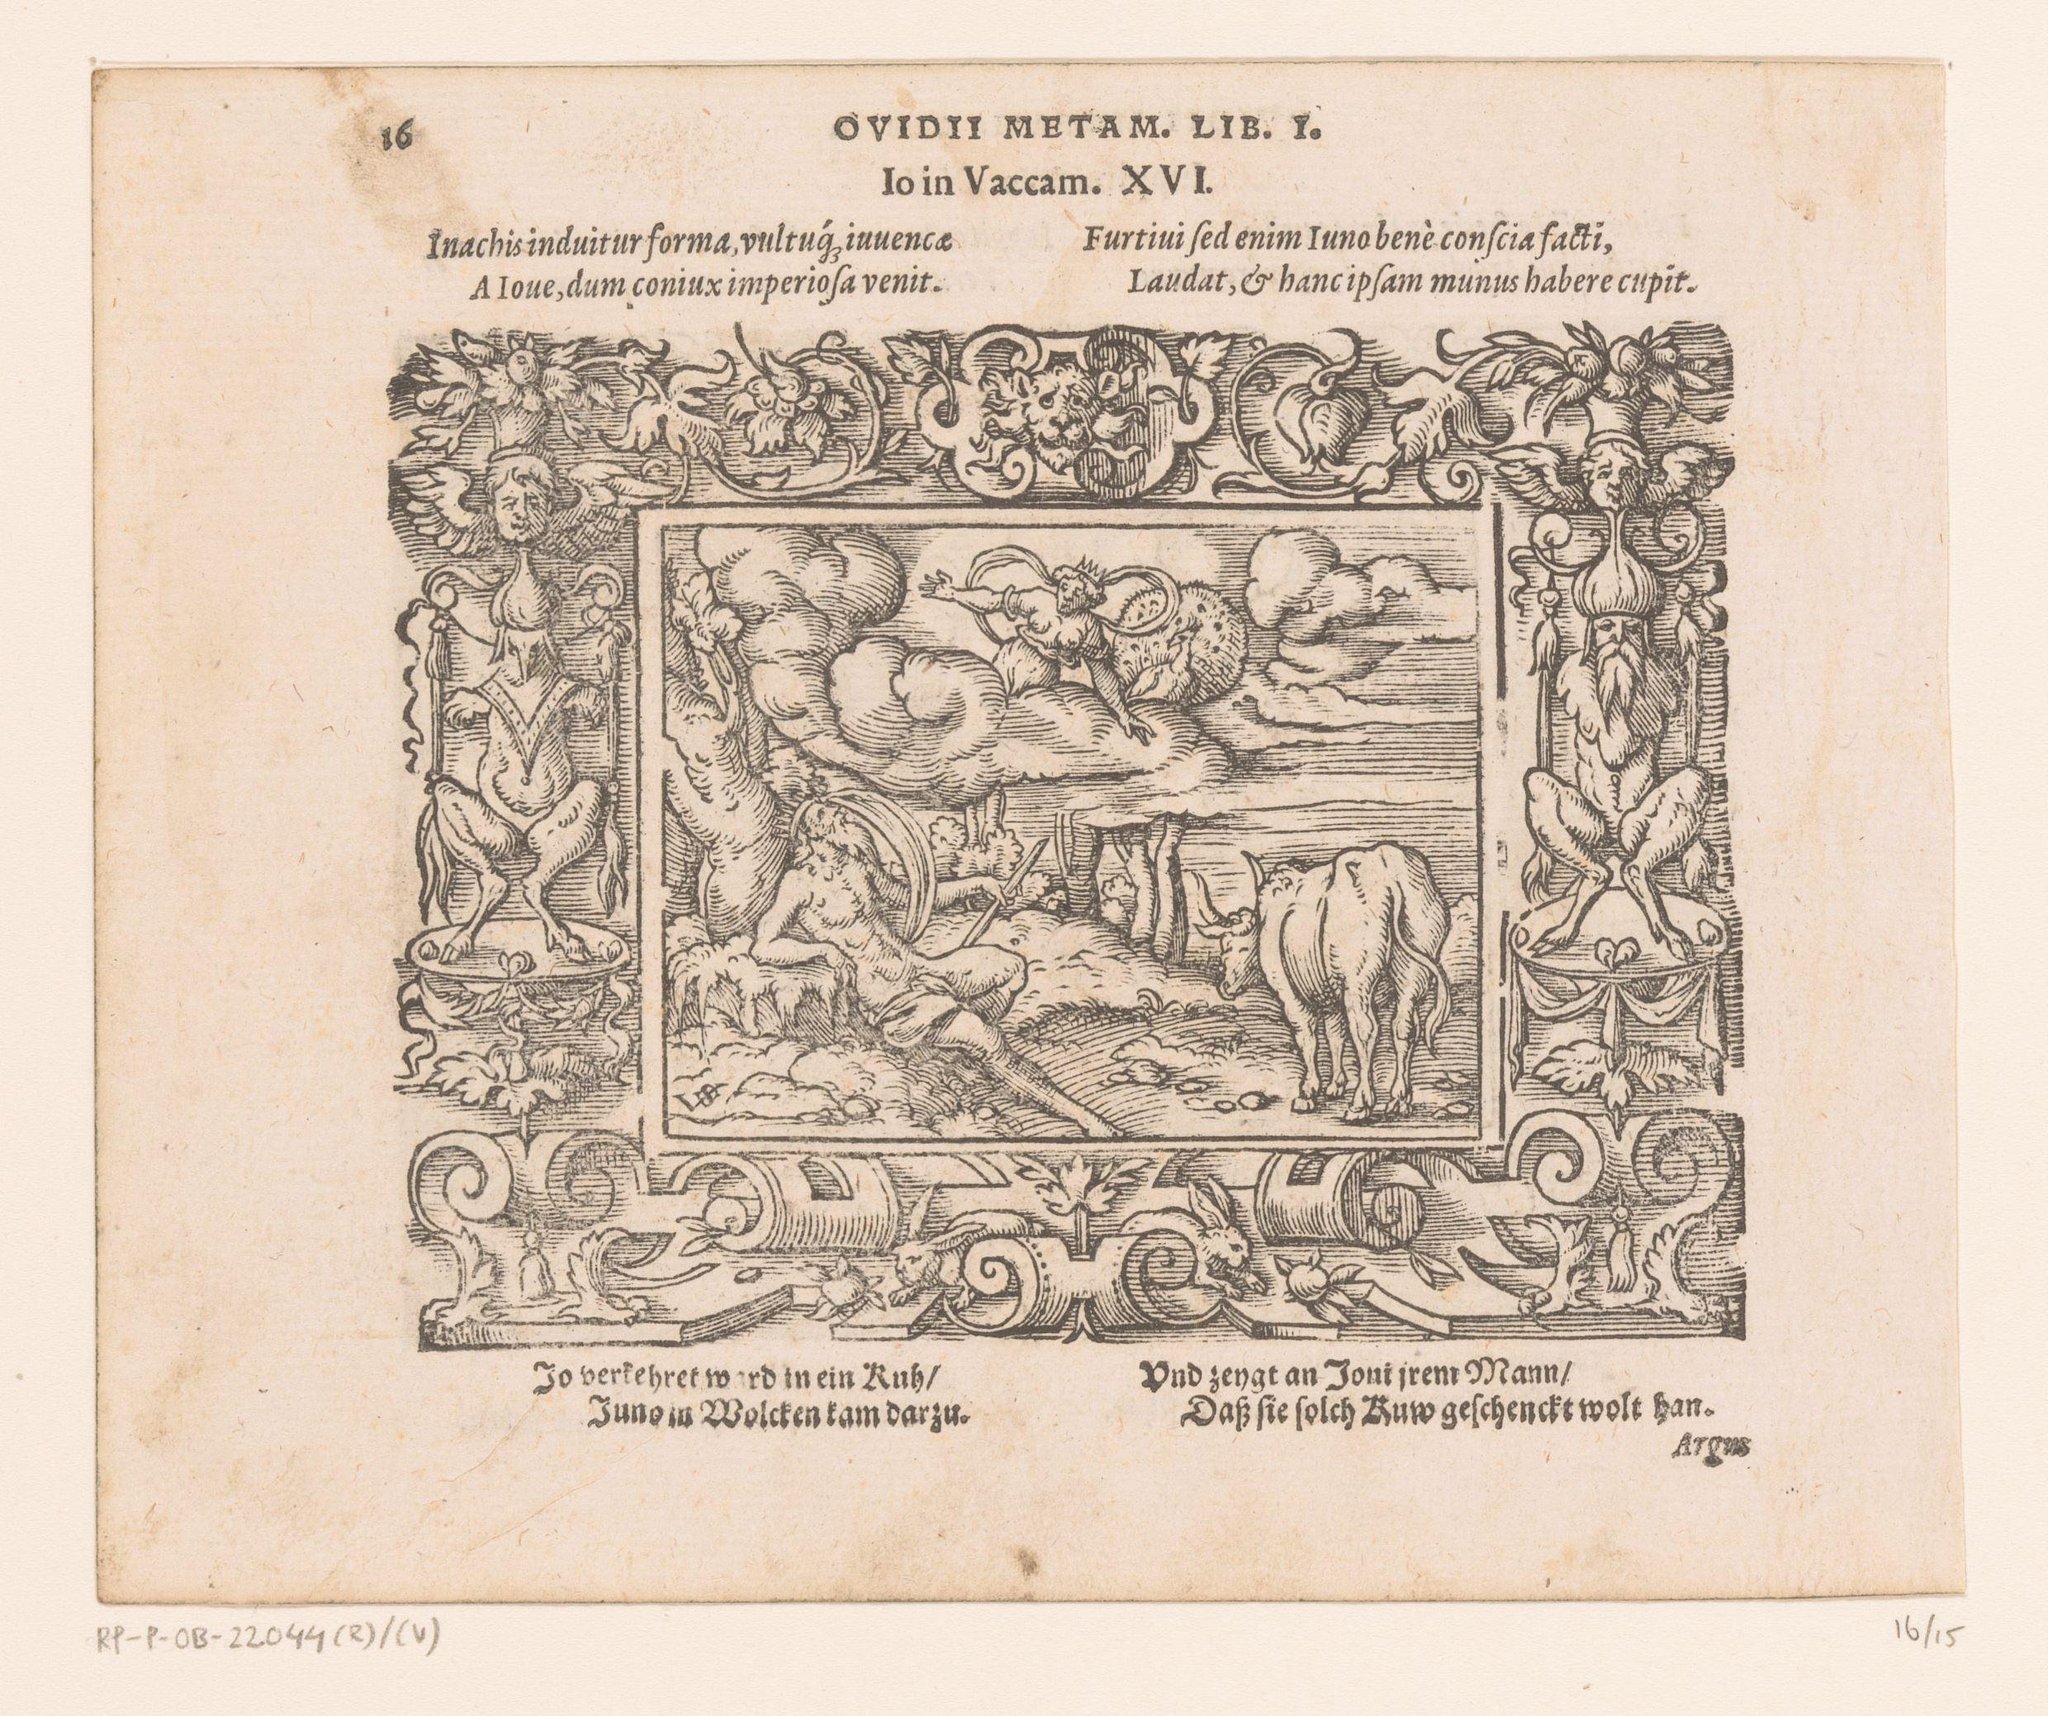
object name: print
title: Io in Vaccam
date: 1569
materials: paper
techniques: letterpress printing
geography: frankfurt am main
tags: io changed into a cow: to avoid detection by juno, jupiter changes io into a cow (ovid, metamorphoses i 611), scrollwork, strapwork ~ ornament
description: Illustratie bij de Metamorfosen van Ovidius, afkomstig uit de publicatie: Posthius, Johannes. Tetrasticha in Ovidii metam. Frankfurt am Main: Georg Rab en Sigmund Feyerabend en erven Weigand Han, 1569. De voorstellingen en ornamentranden van deze boekillustraties zijn van twee aparte blokken gedrukt. Beide werden afzonderlijk van elkaar ook gebruikt voor andere publicaties, en de ornamentranden werden eveneens binnen deze publicatie meerdere keren gebruikt.